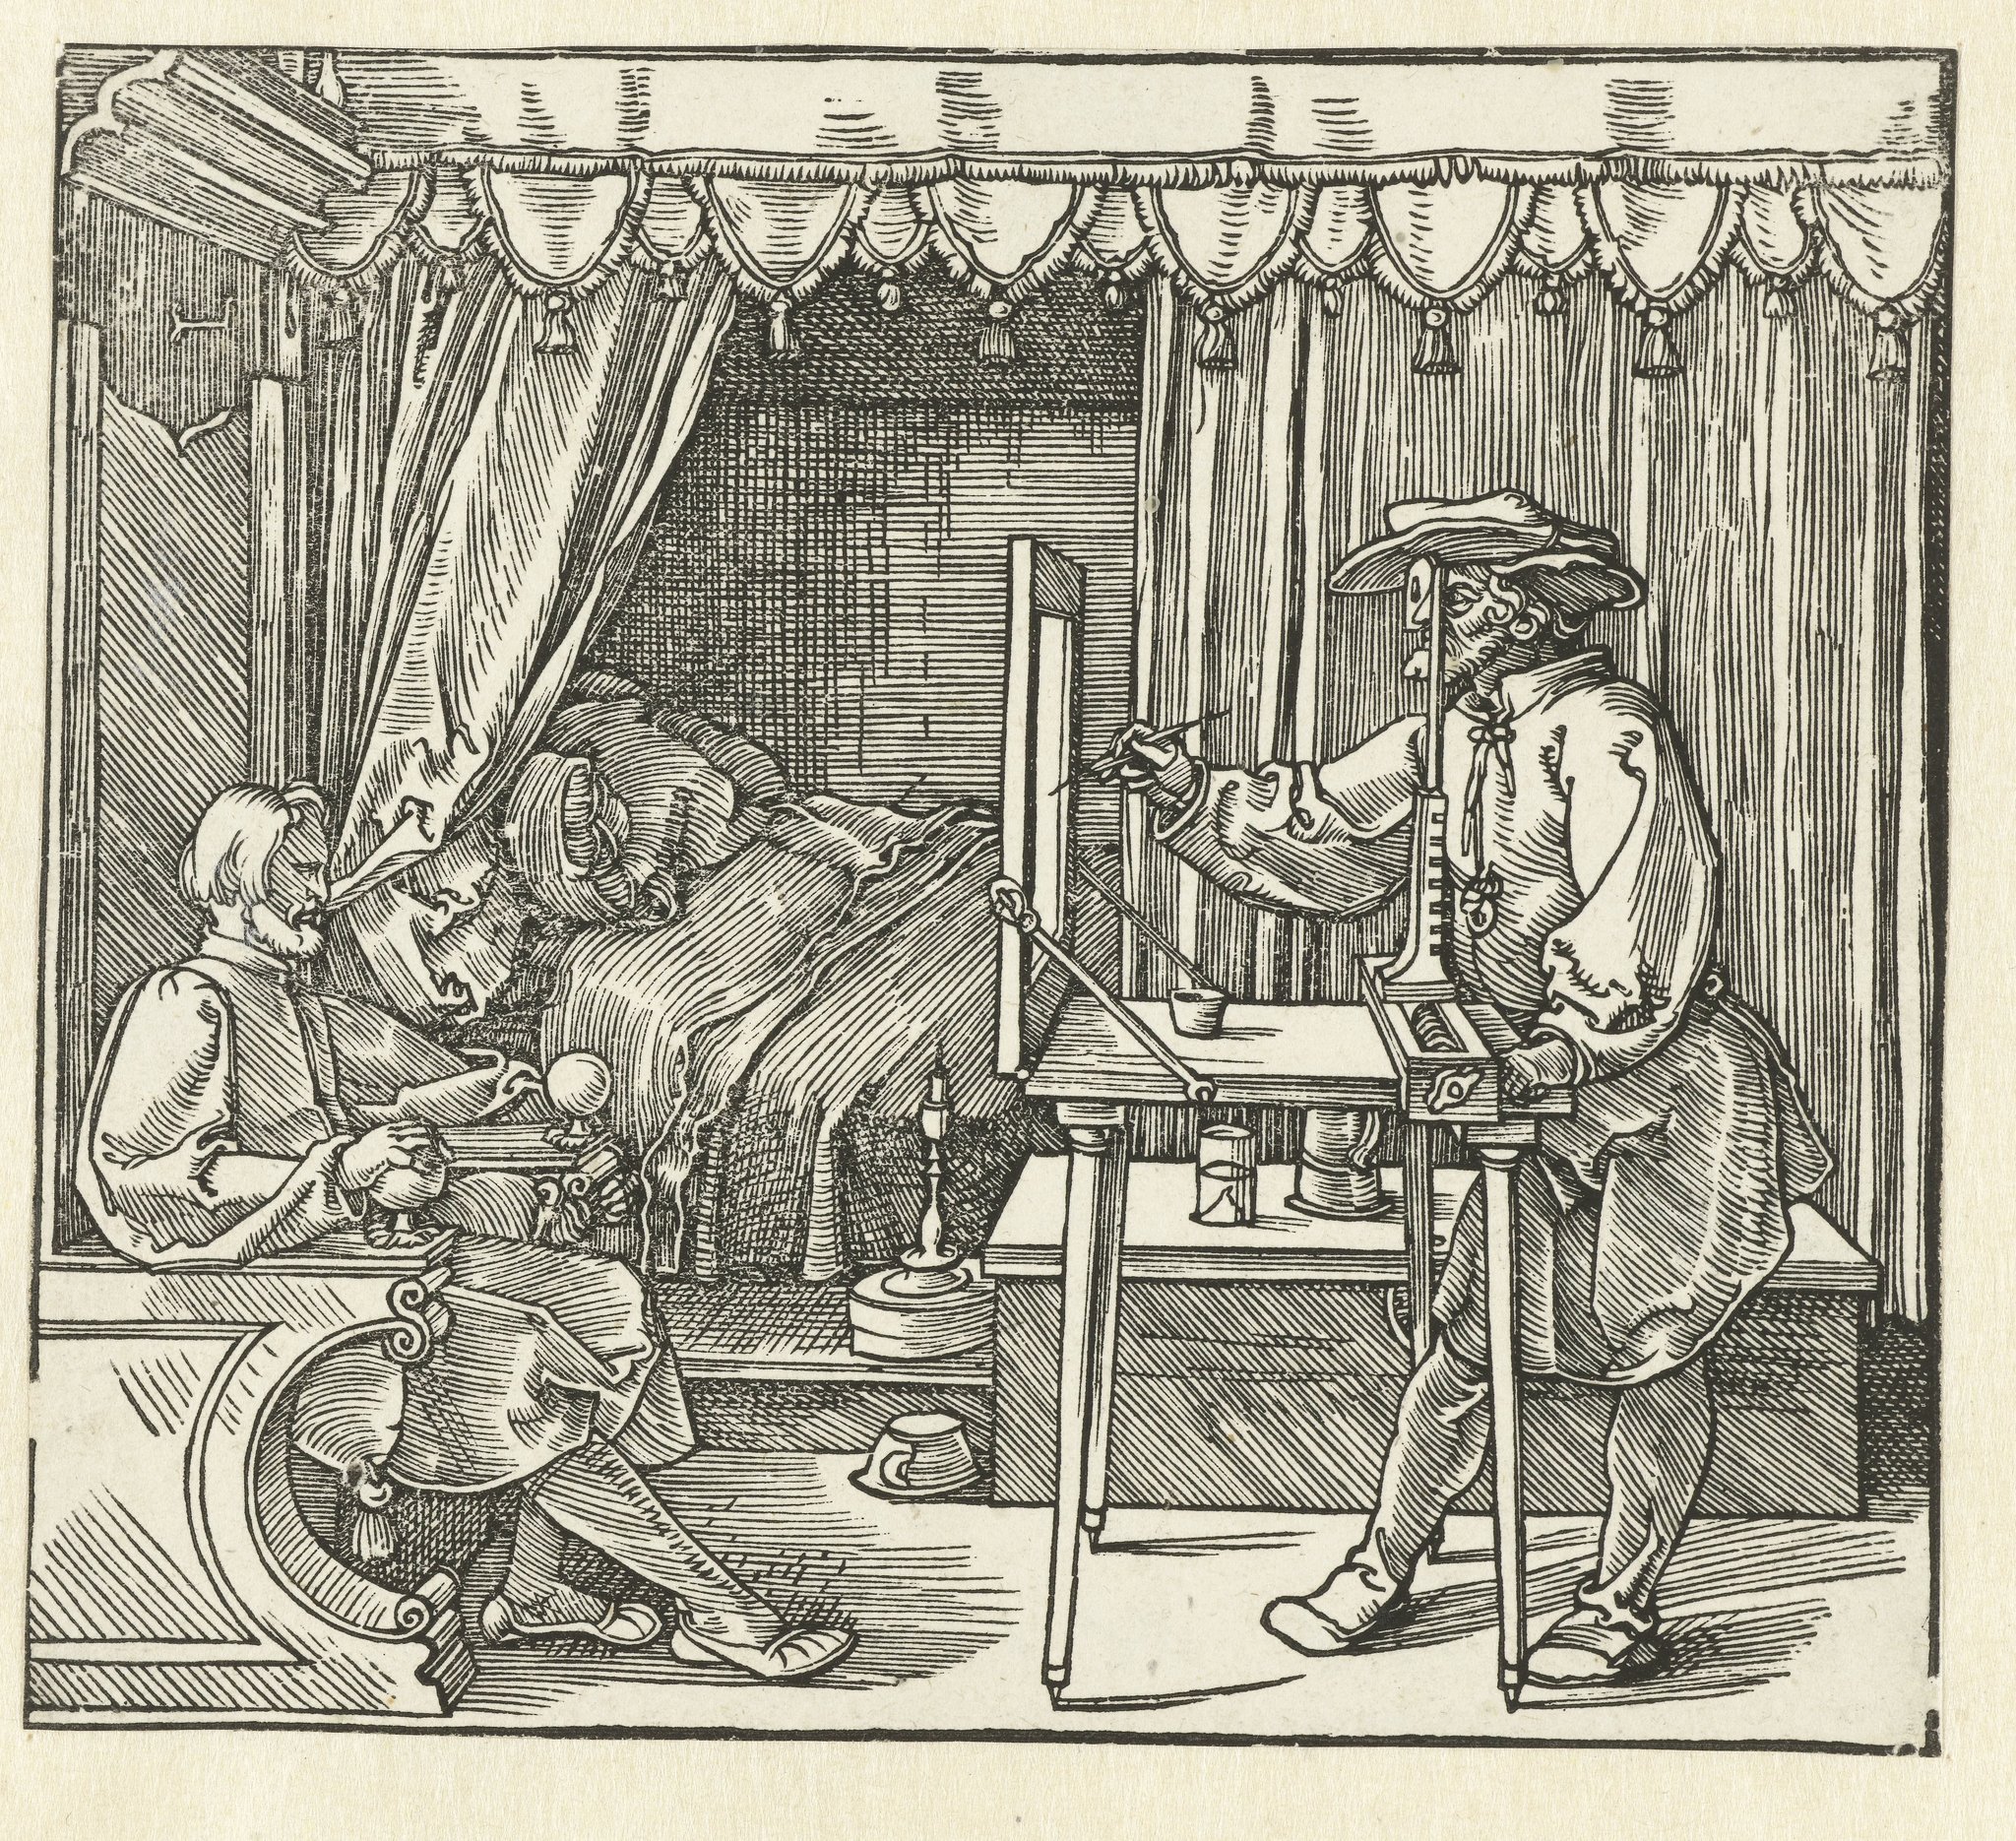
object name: print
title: Een tekenaar tekent een portret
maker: albrecht dürer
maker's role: draughtsman, painter, print maker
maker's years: 1471-1528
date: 1525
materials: paper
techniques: woodcut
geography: nuremberg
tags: instruments for perspective drawing, draughtsman at work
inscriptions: collector's mark: Lugt 240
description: De tekenaar bedient zich van een 'vetri piani' of glastafel-apparaat. Een glasplaat in een houten raam wordt rechtstandig tussen de tekenaar en zijn model geplaatst. Met een vettige stift worden de contouren van het beeld op het glas getekend. Deze tekening wordt op papier overgebracht. Het instrument werd door Leonardo da Vinci aanbevolen voor het tekenen van landschappen. Bij Dürer wordt het gebruikt voor het tekenen van een portret.